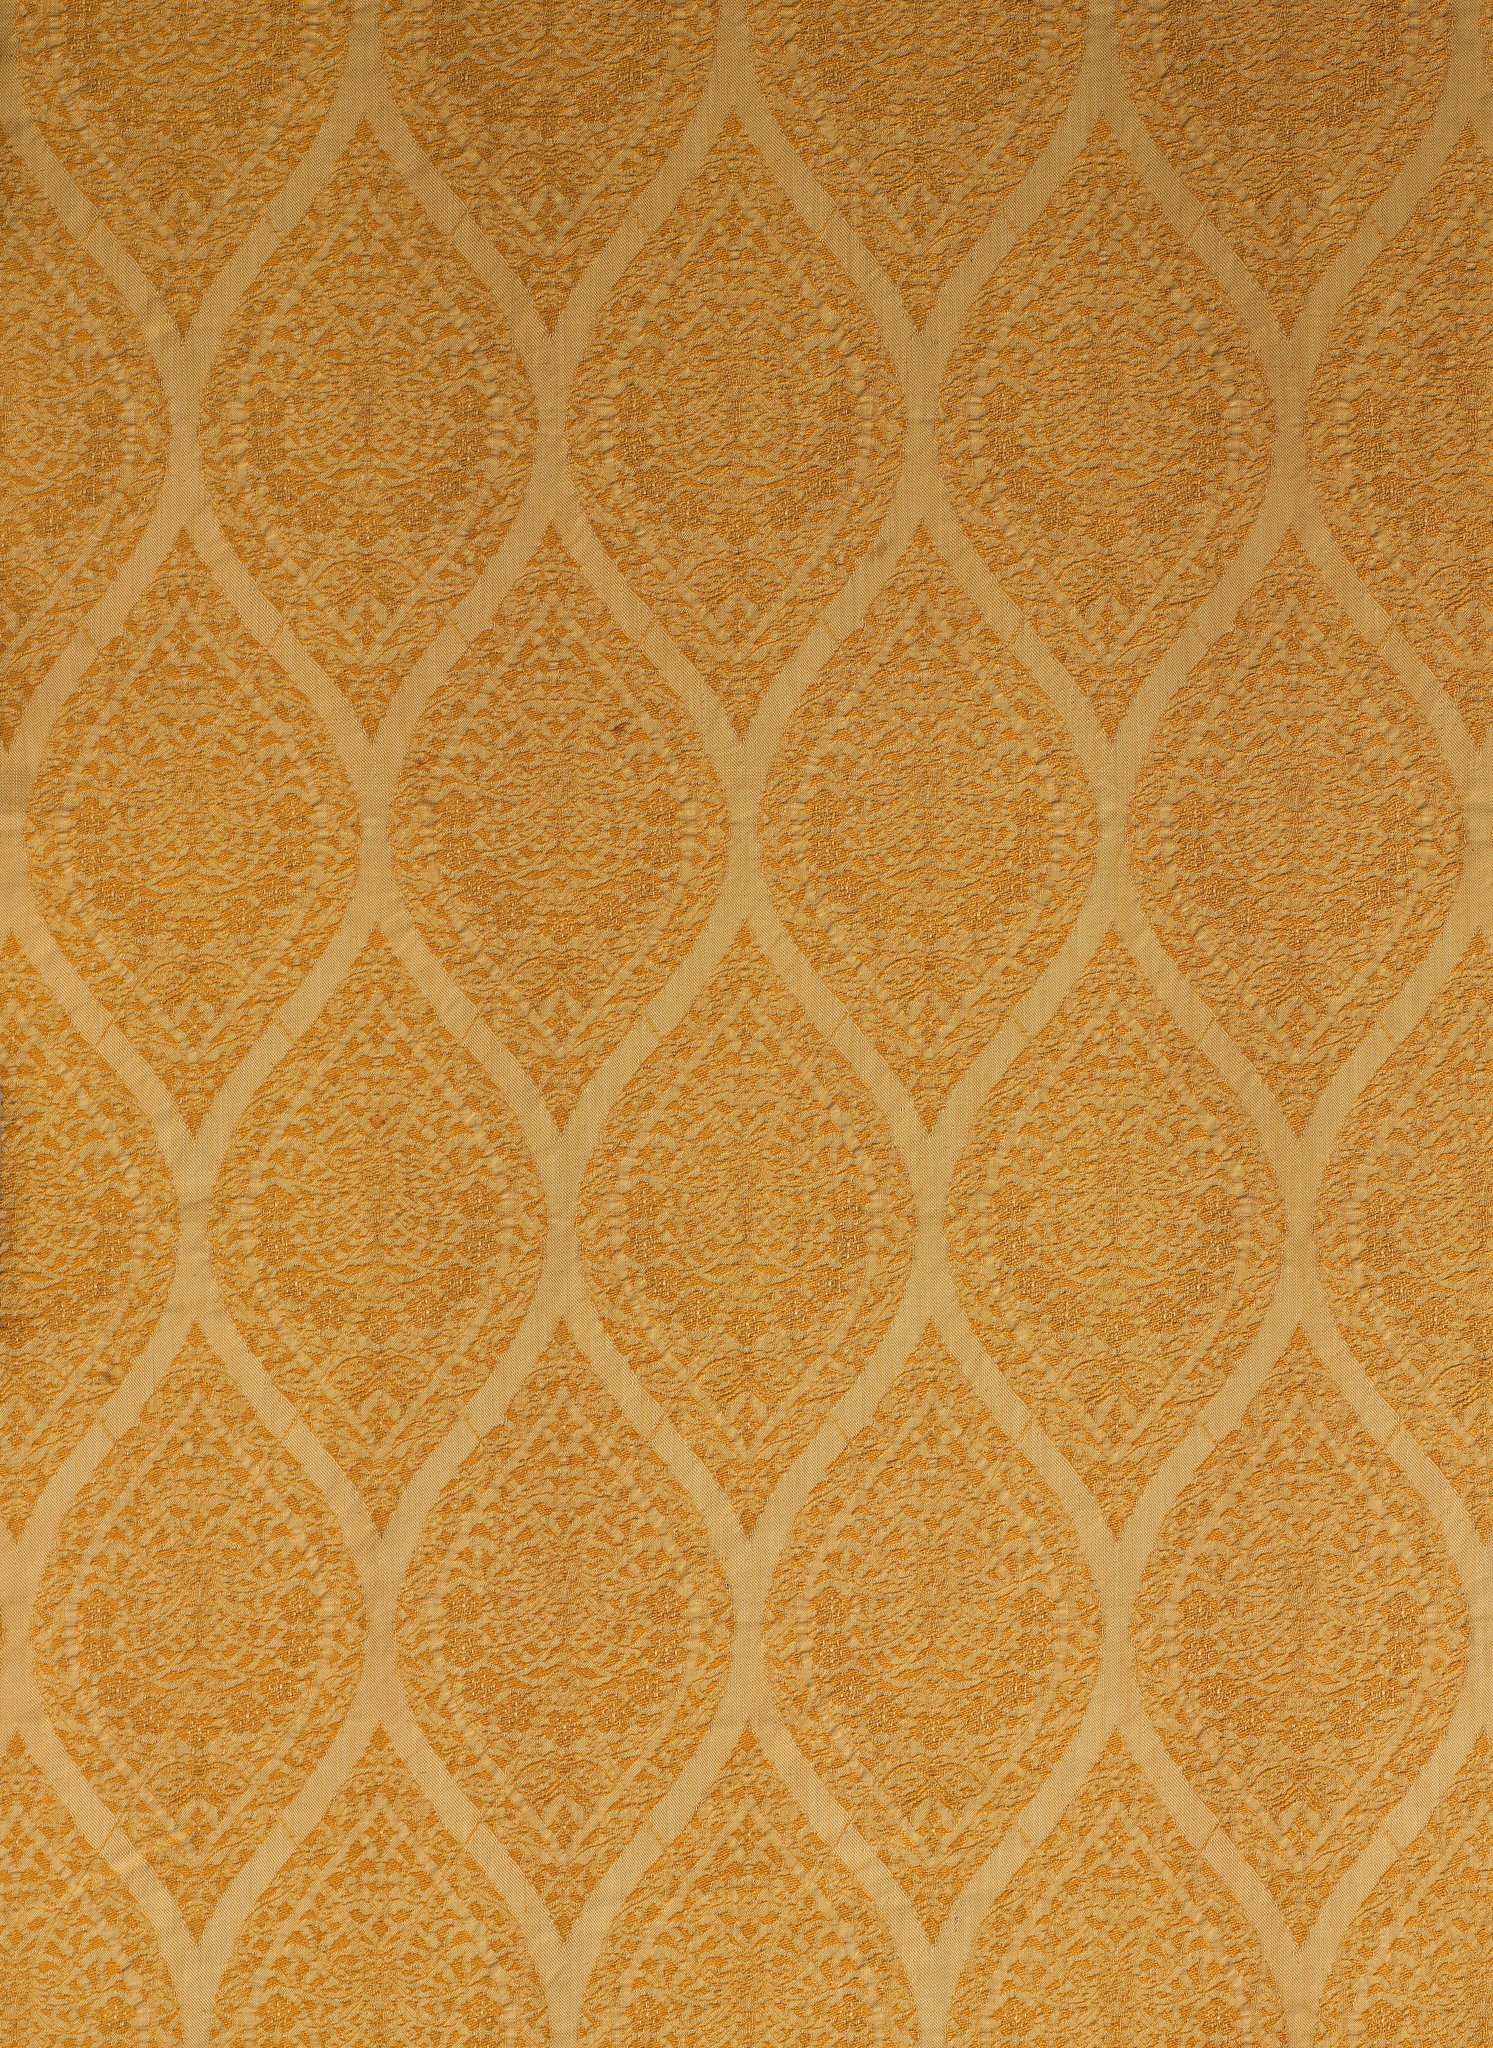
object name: curtain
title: Gordijn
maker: theo nieuwenhuis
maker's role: designer, draughtsman, print maker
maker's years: 1866-1951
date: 1880-1949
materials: cotton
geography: helmond